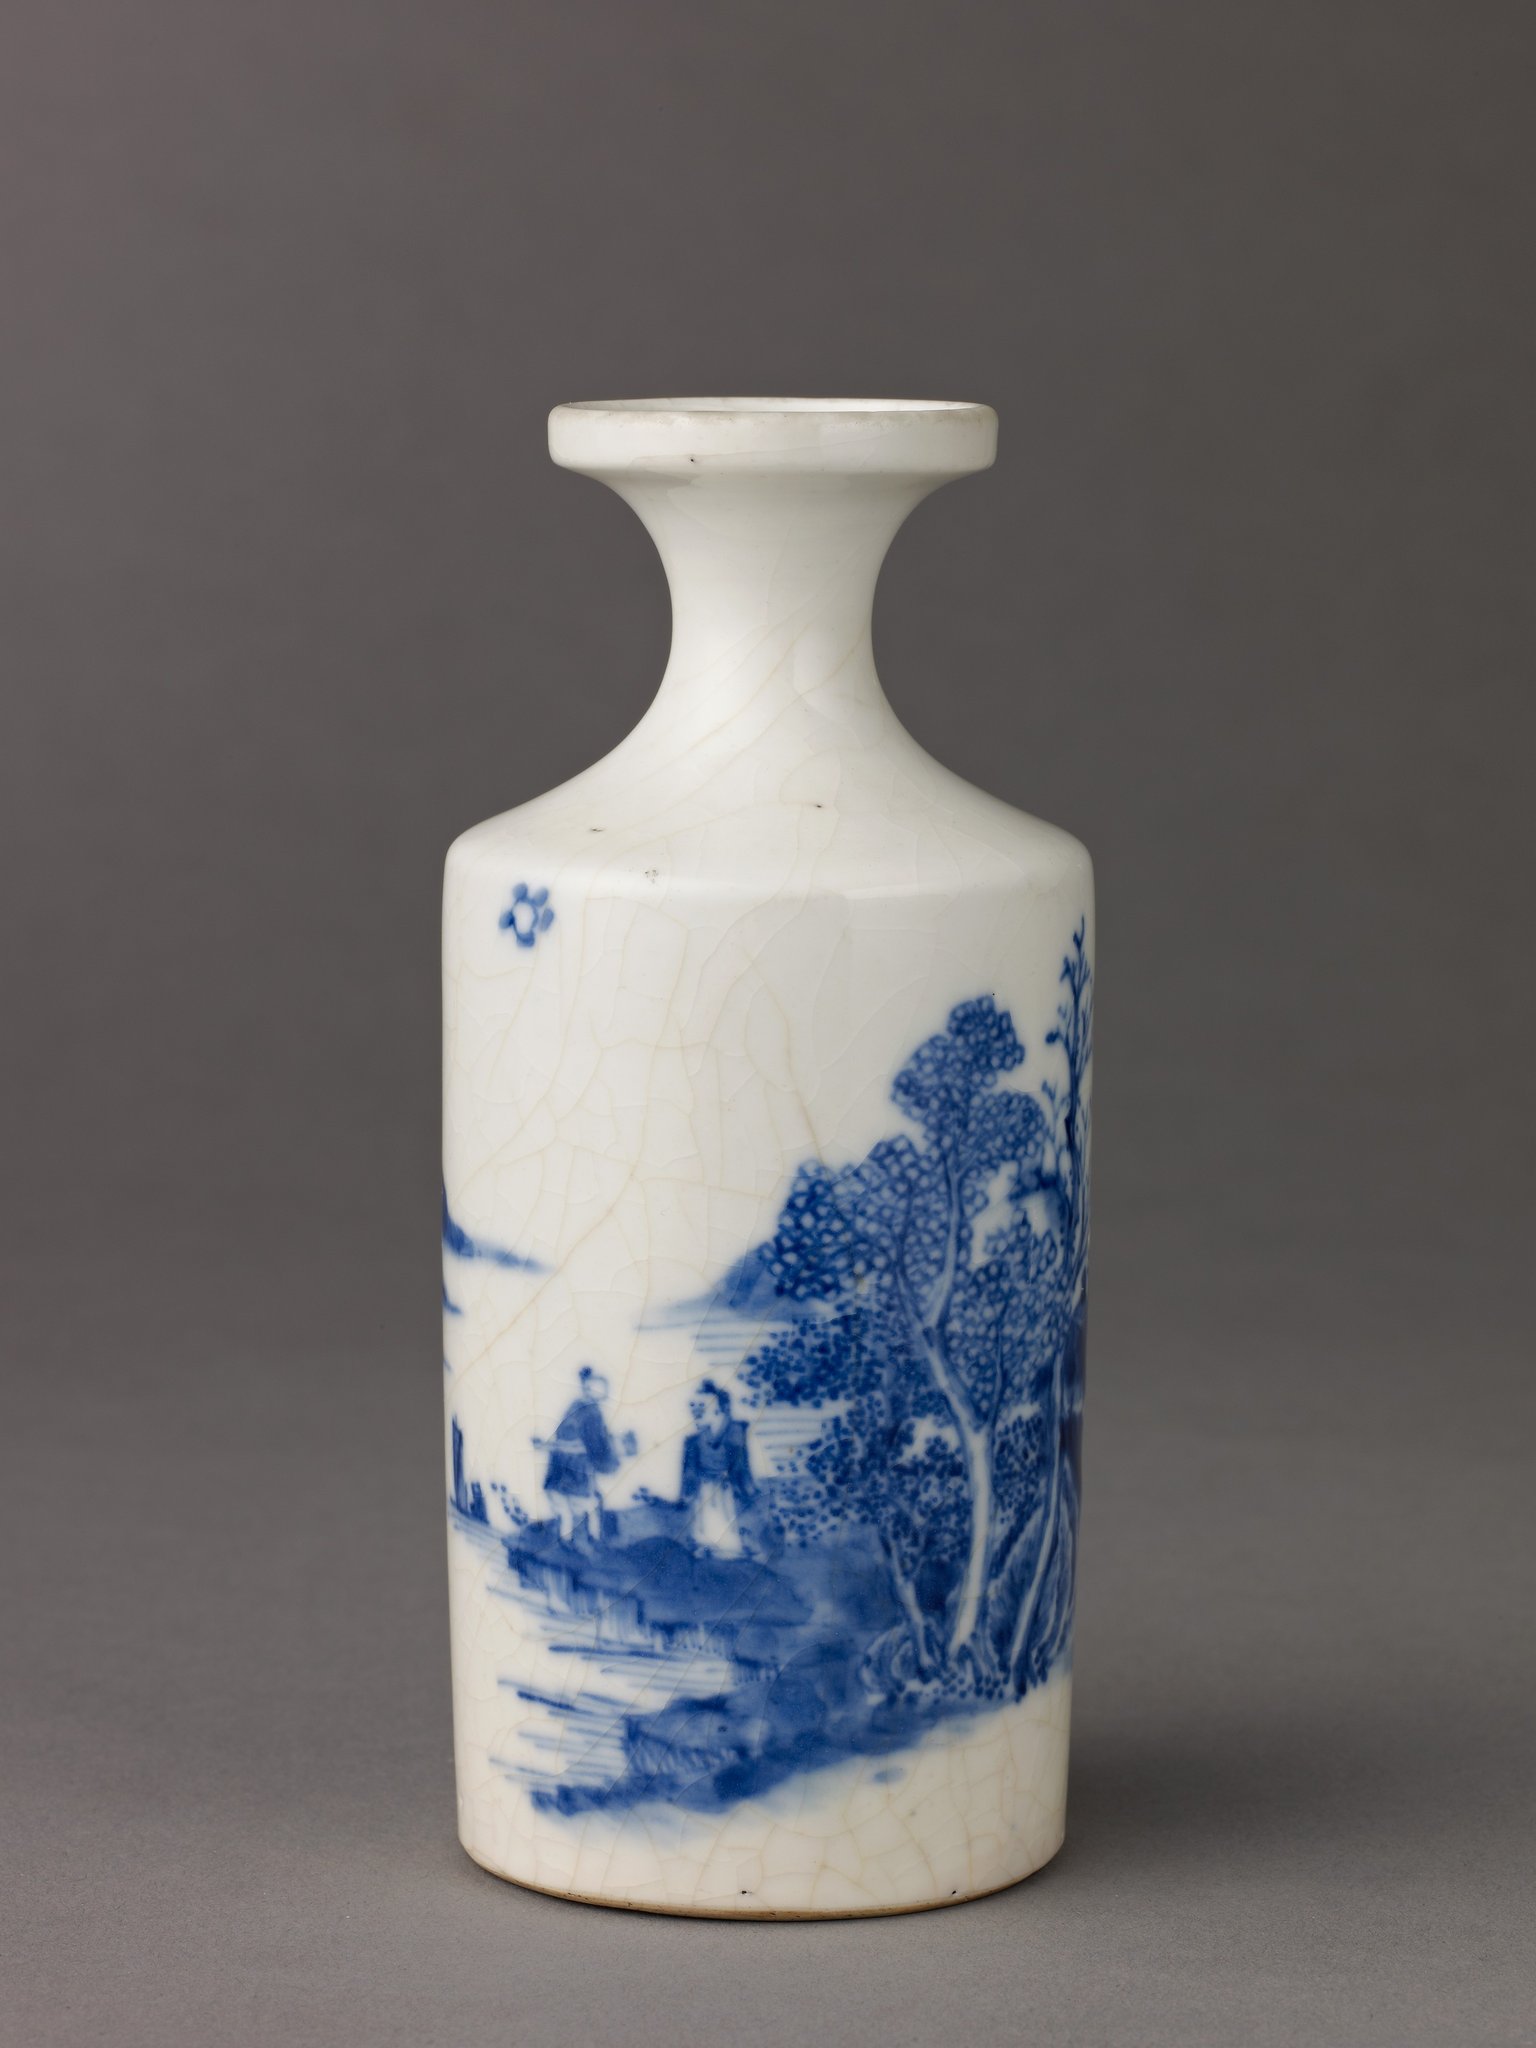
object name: vase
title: Small bottle-shaped vase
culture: chinese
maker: chinese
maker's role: artist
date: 1701-1800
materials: porcelain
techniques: painting, underglaze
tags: human figures,trees